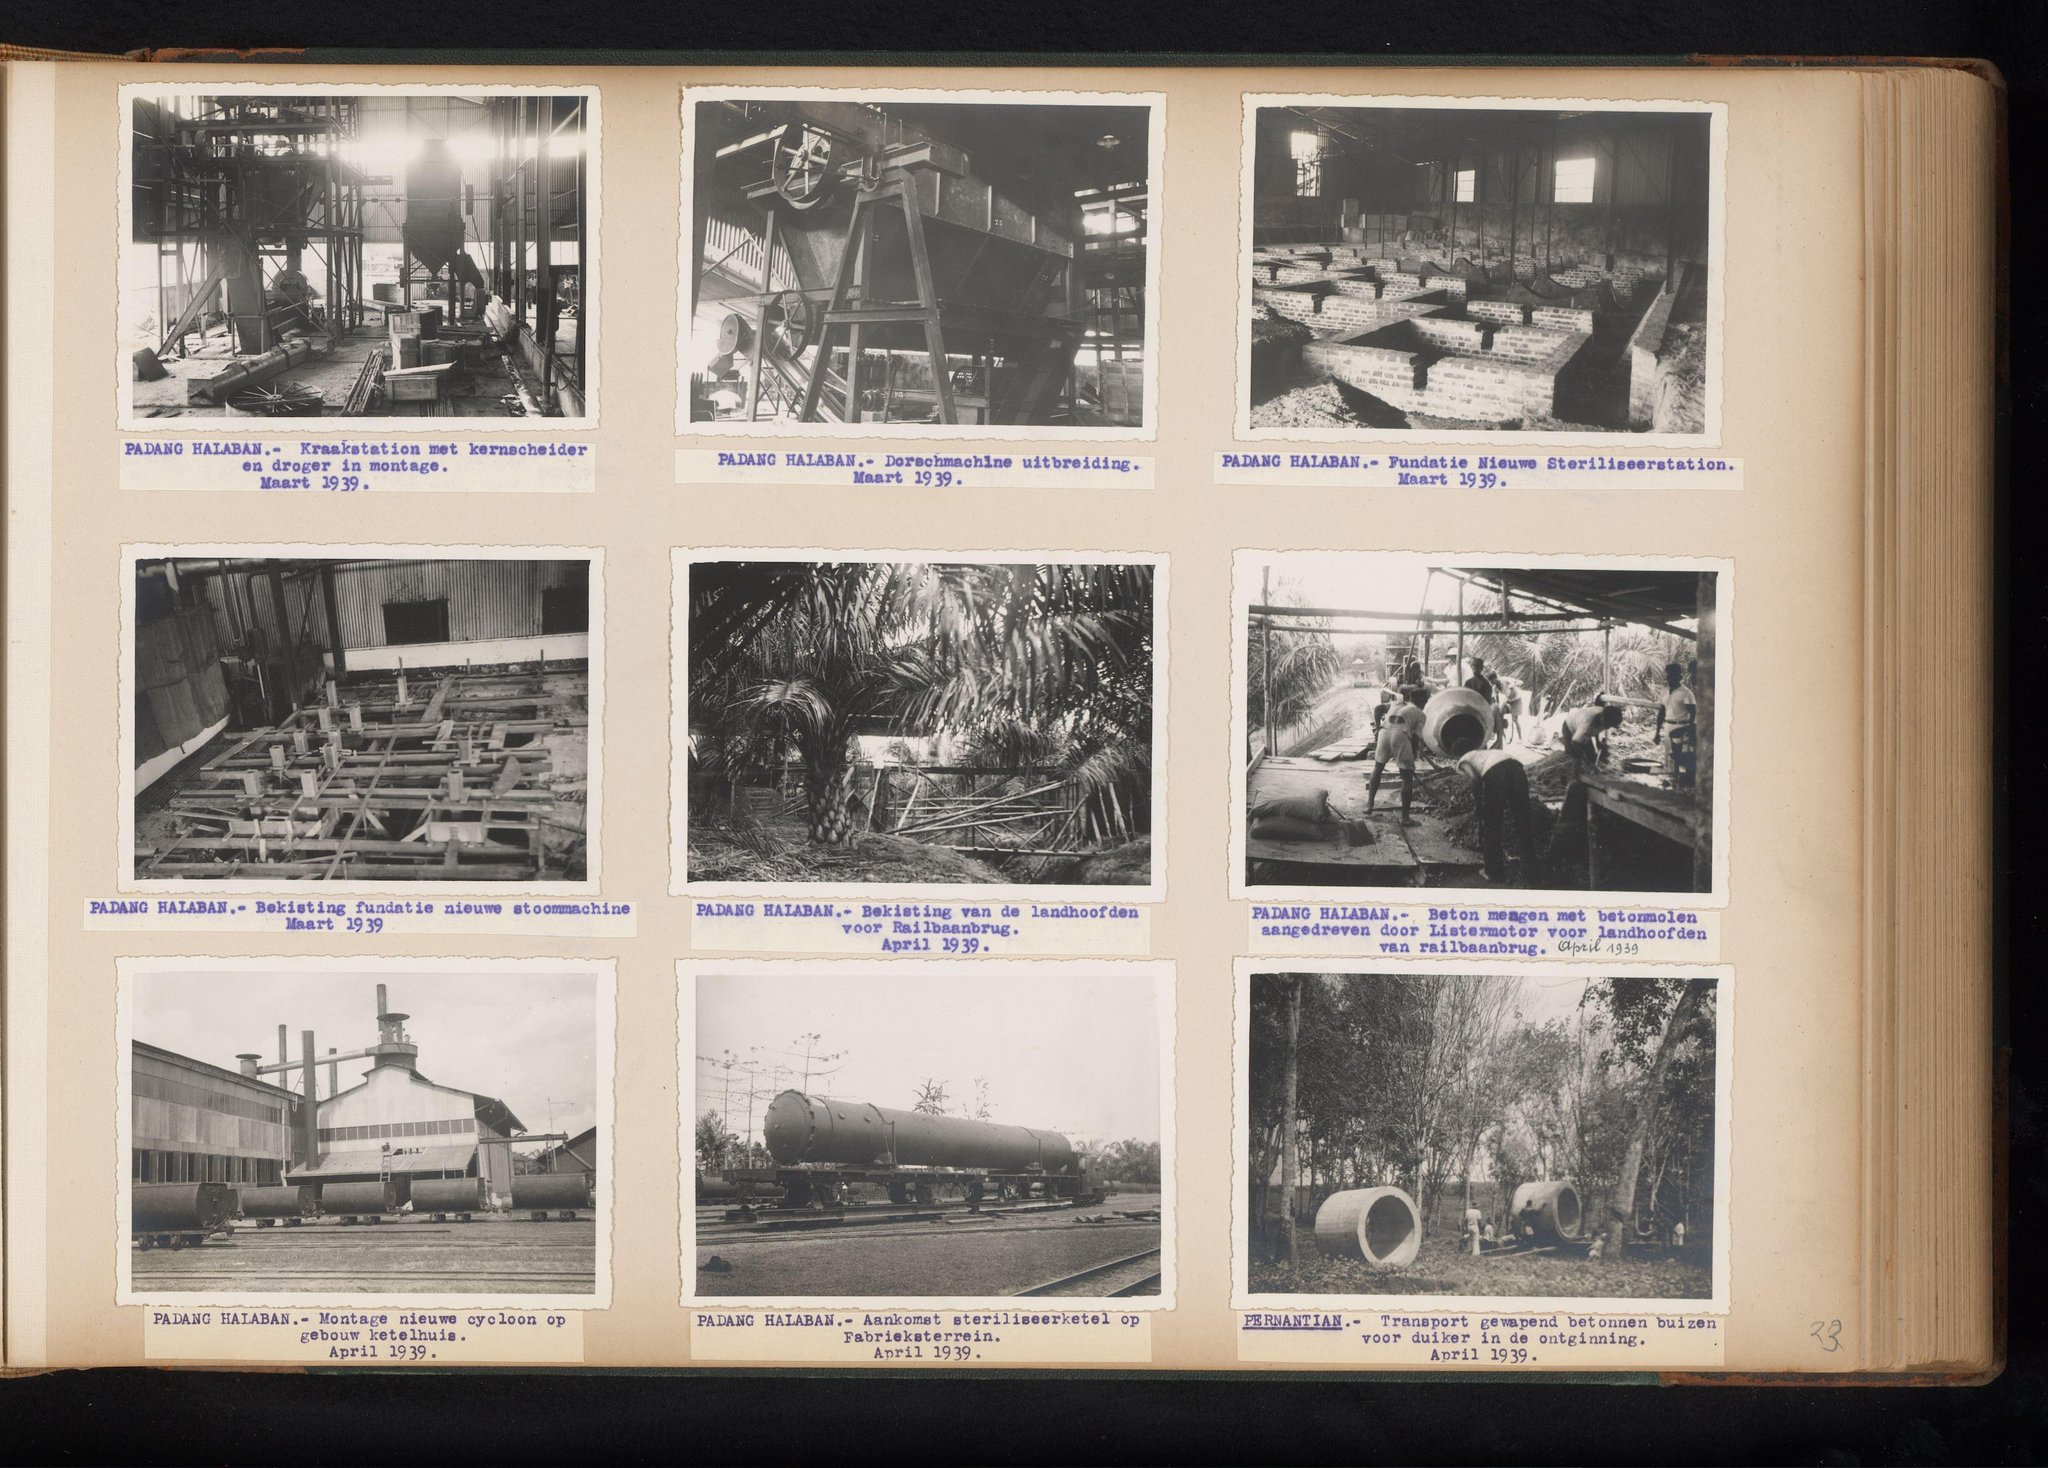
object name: album leaf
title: Werk aan de palmoliefabriek op Padang Halaban, 1939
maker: Anonymous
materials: cardboard, photographic support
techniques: gelatin silver print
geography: sumatra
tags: asiatic races and peoples (indonesians), plantation, interior of industrial structures (regardless of the materials processed or the products made, (non-fruit) products of plants or trees: palm oil, exterior of industrial structures, factories, sumatra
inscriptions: inscription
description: Blad met negen foto's van machines en verbouwingen van palmoliefabriek op Padang Halaban, maart-april 1939. Met etiketten met onderschriften onder de foto's. Onderdeel van het fotoalbum over de plantages Pernantian en Brussel van de Sumatra Caoutchouc Maatschappij op de Oostkust van Sumatra in de jaren 1935-1939.